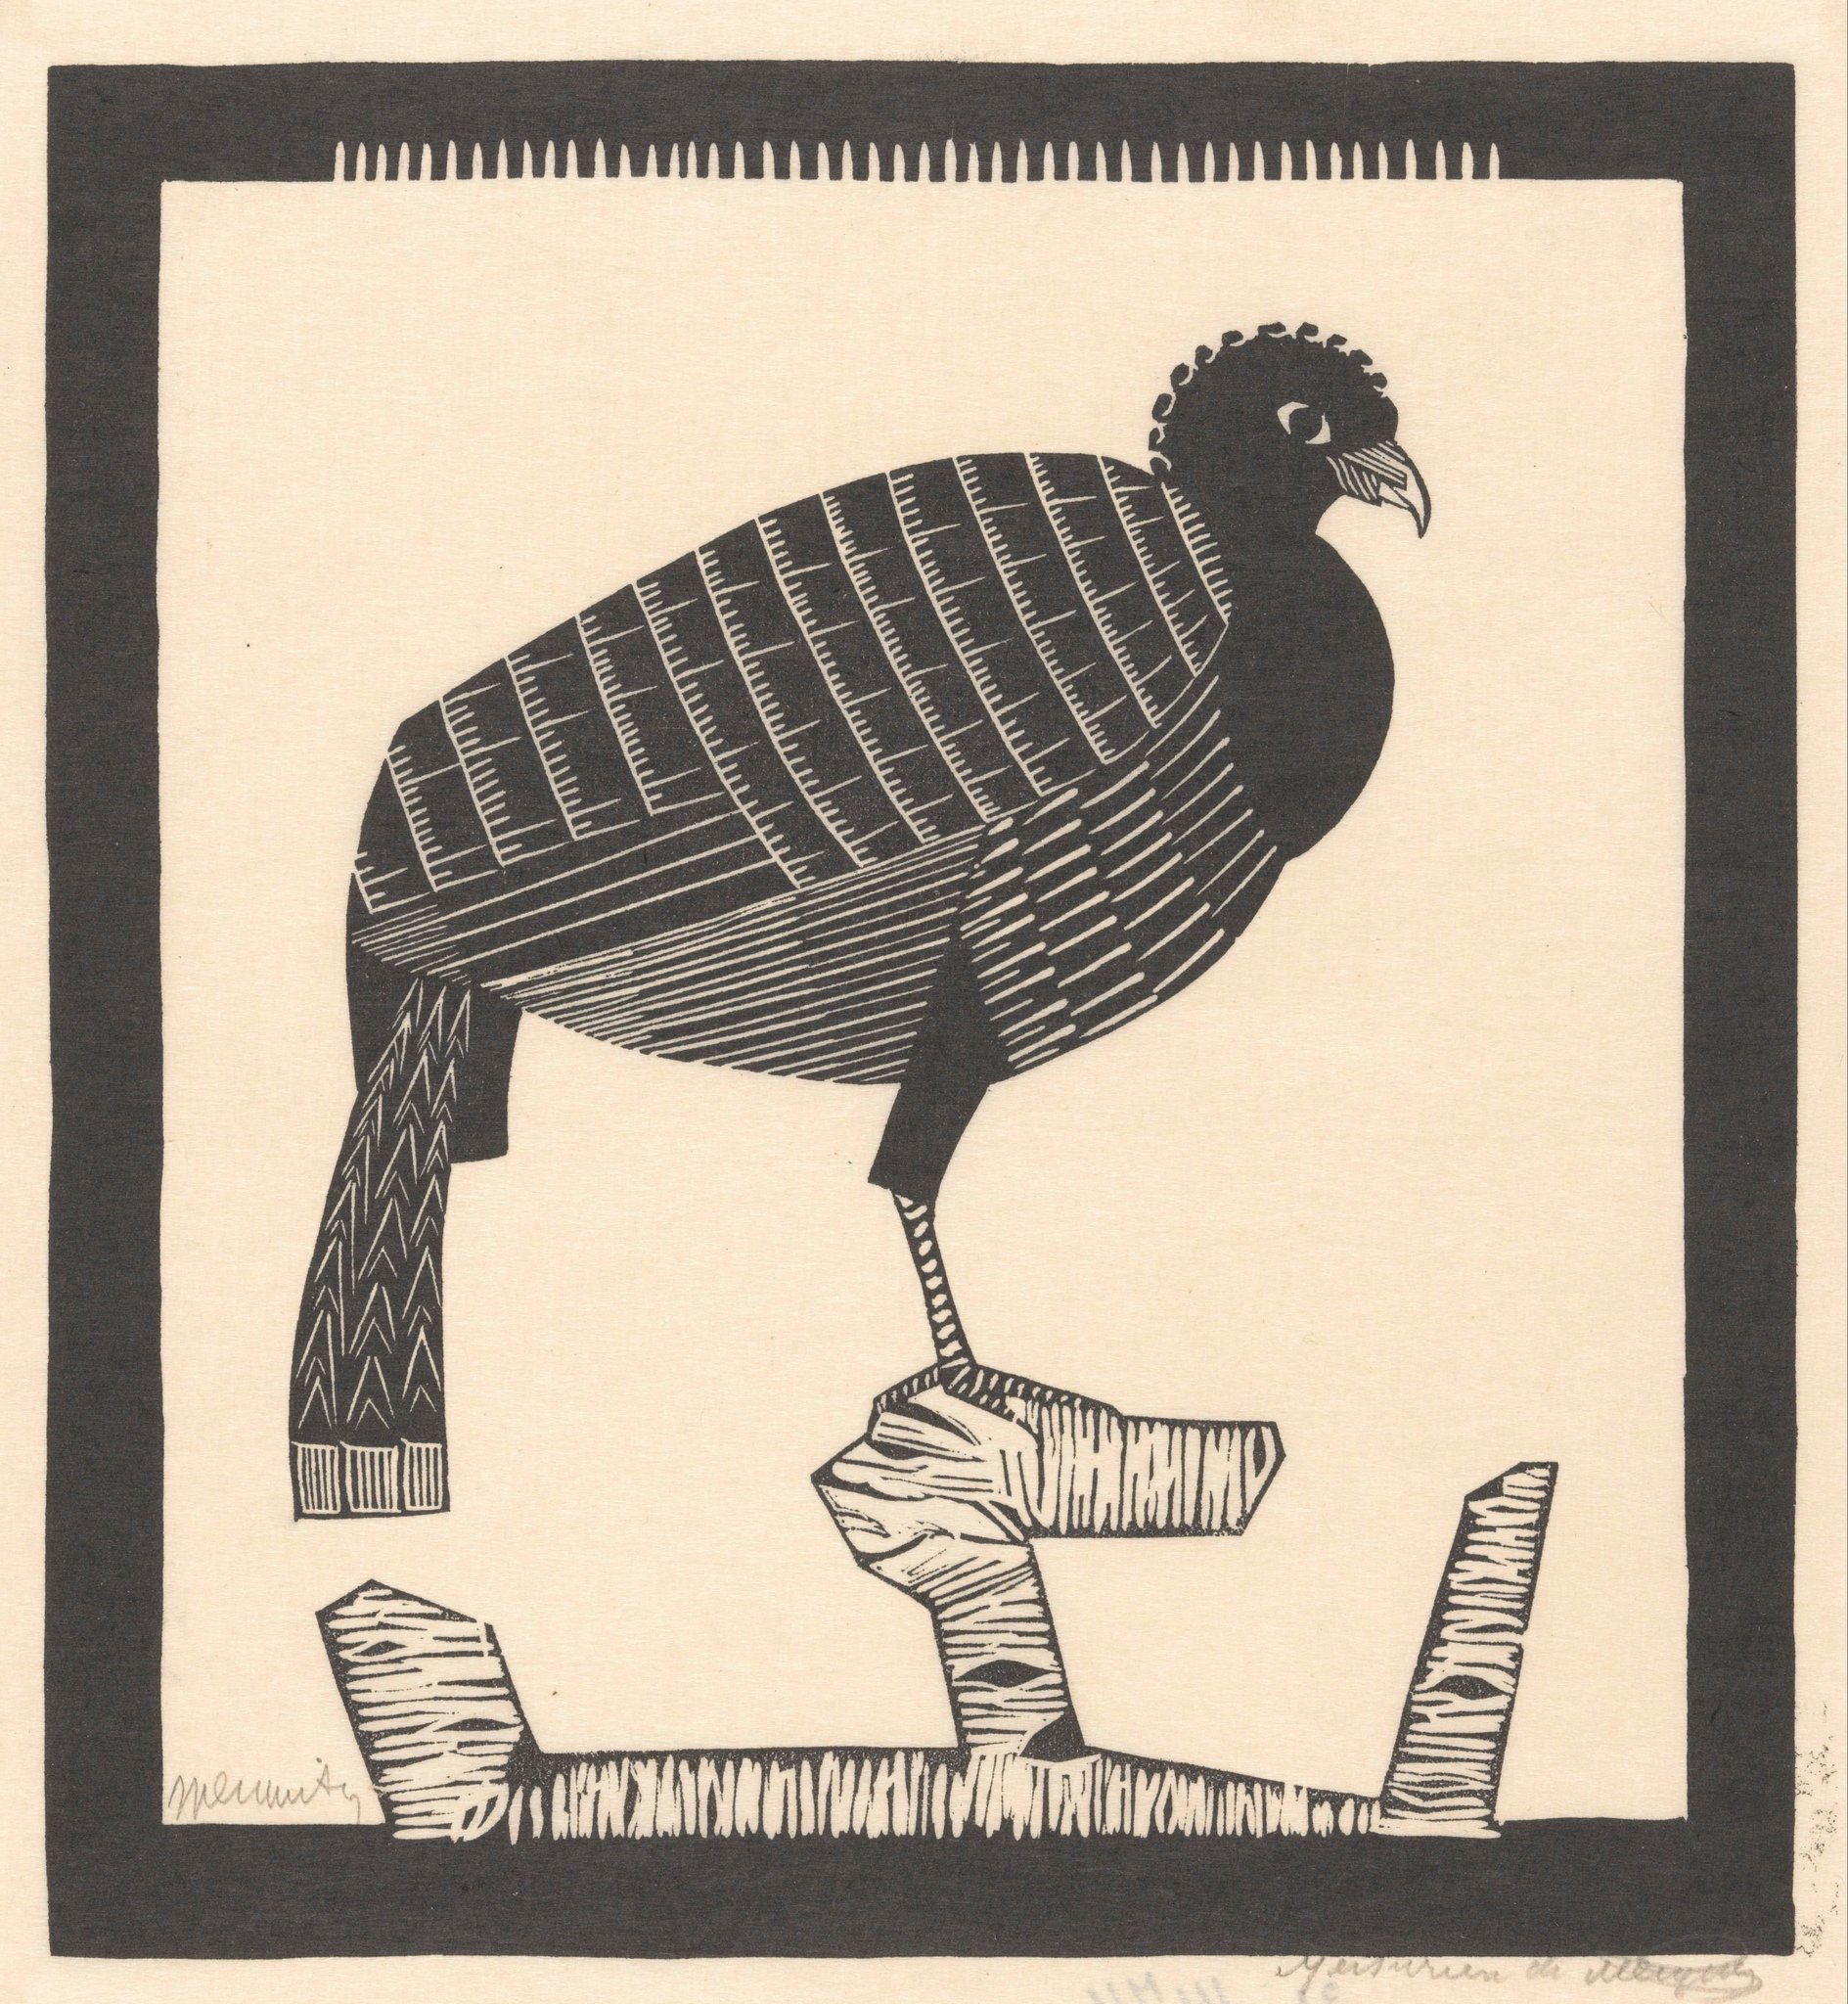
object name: print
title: Pauwies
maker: samuel jessurun de mesquita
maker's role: draughtsman, print maker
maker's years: 1868-1944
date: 1926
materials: paper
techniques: woodcut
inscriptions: signature: ‘jessurun de mesquita’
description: Vogel met kromme snavel en ellipsvormig lichaan en krullen op het hoofd, staand op tak.